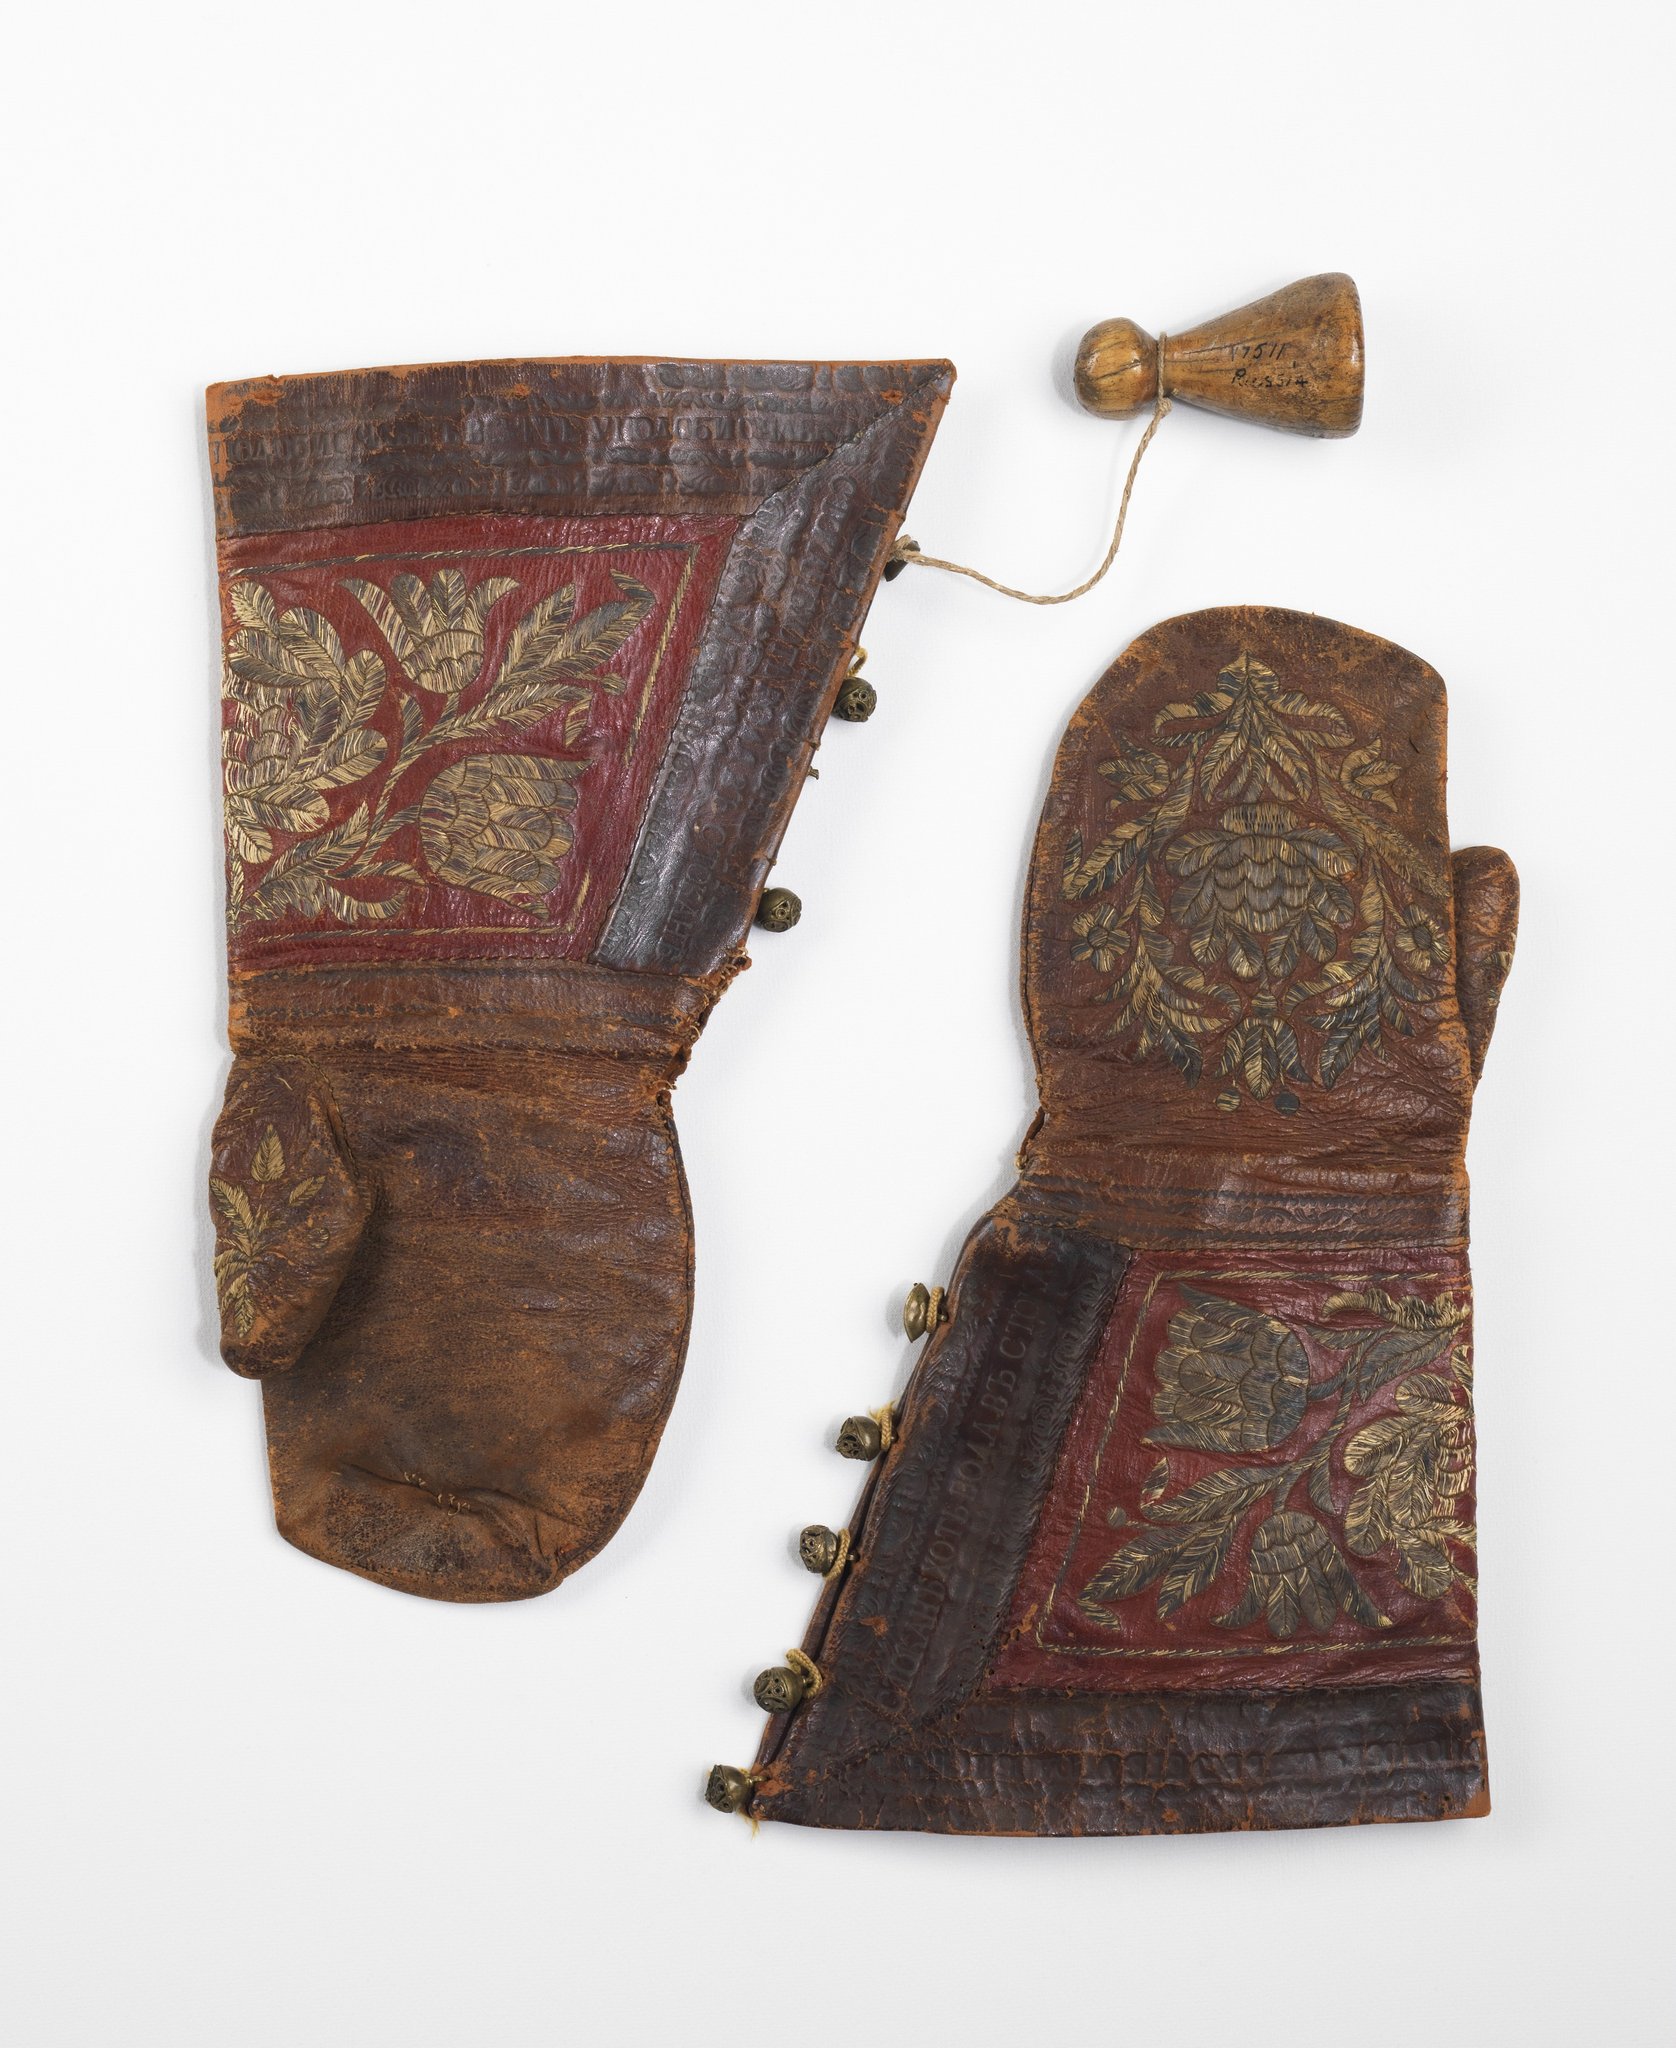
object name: mitten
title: Mittens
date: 1667-1700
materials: bone, leather, metal